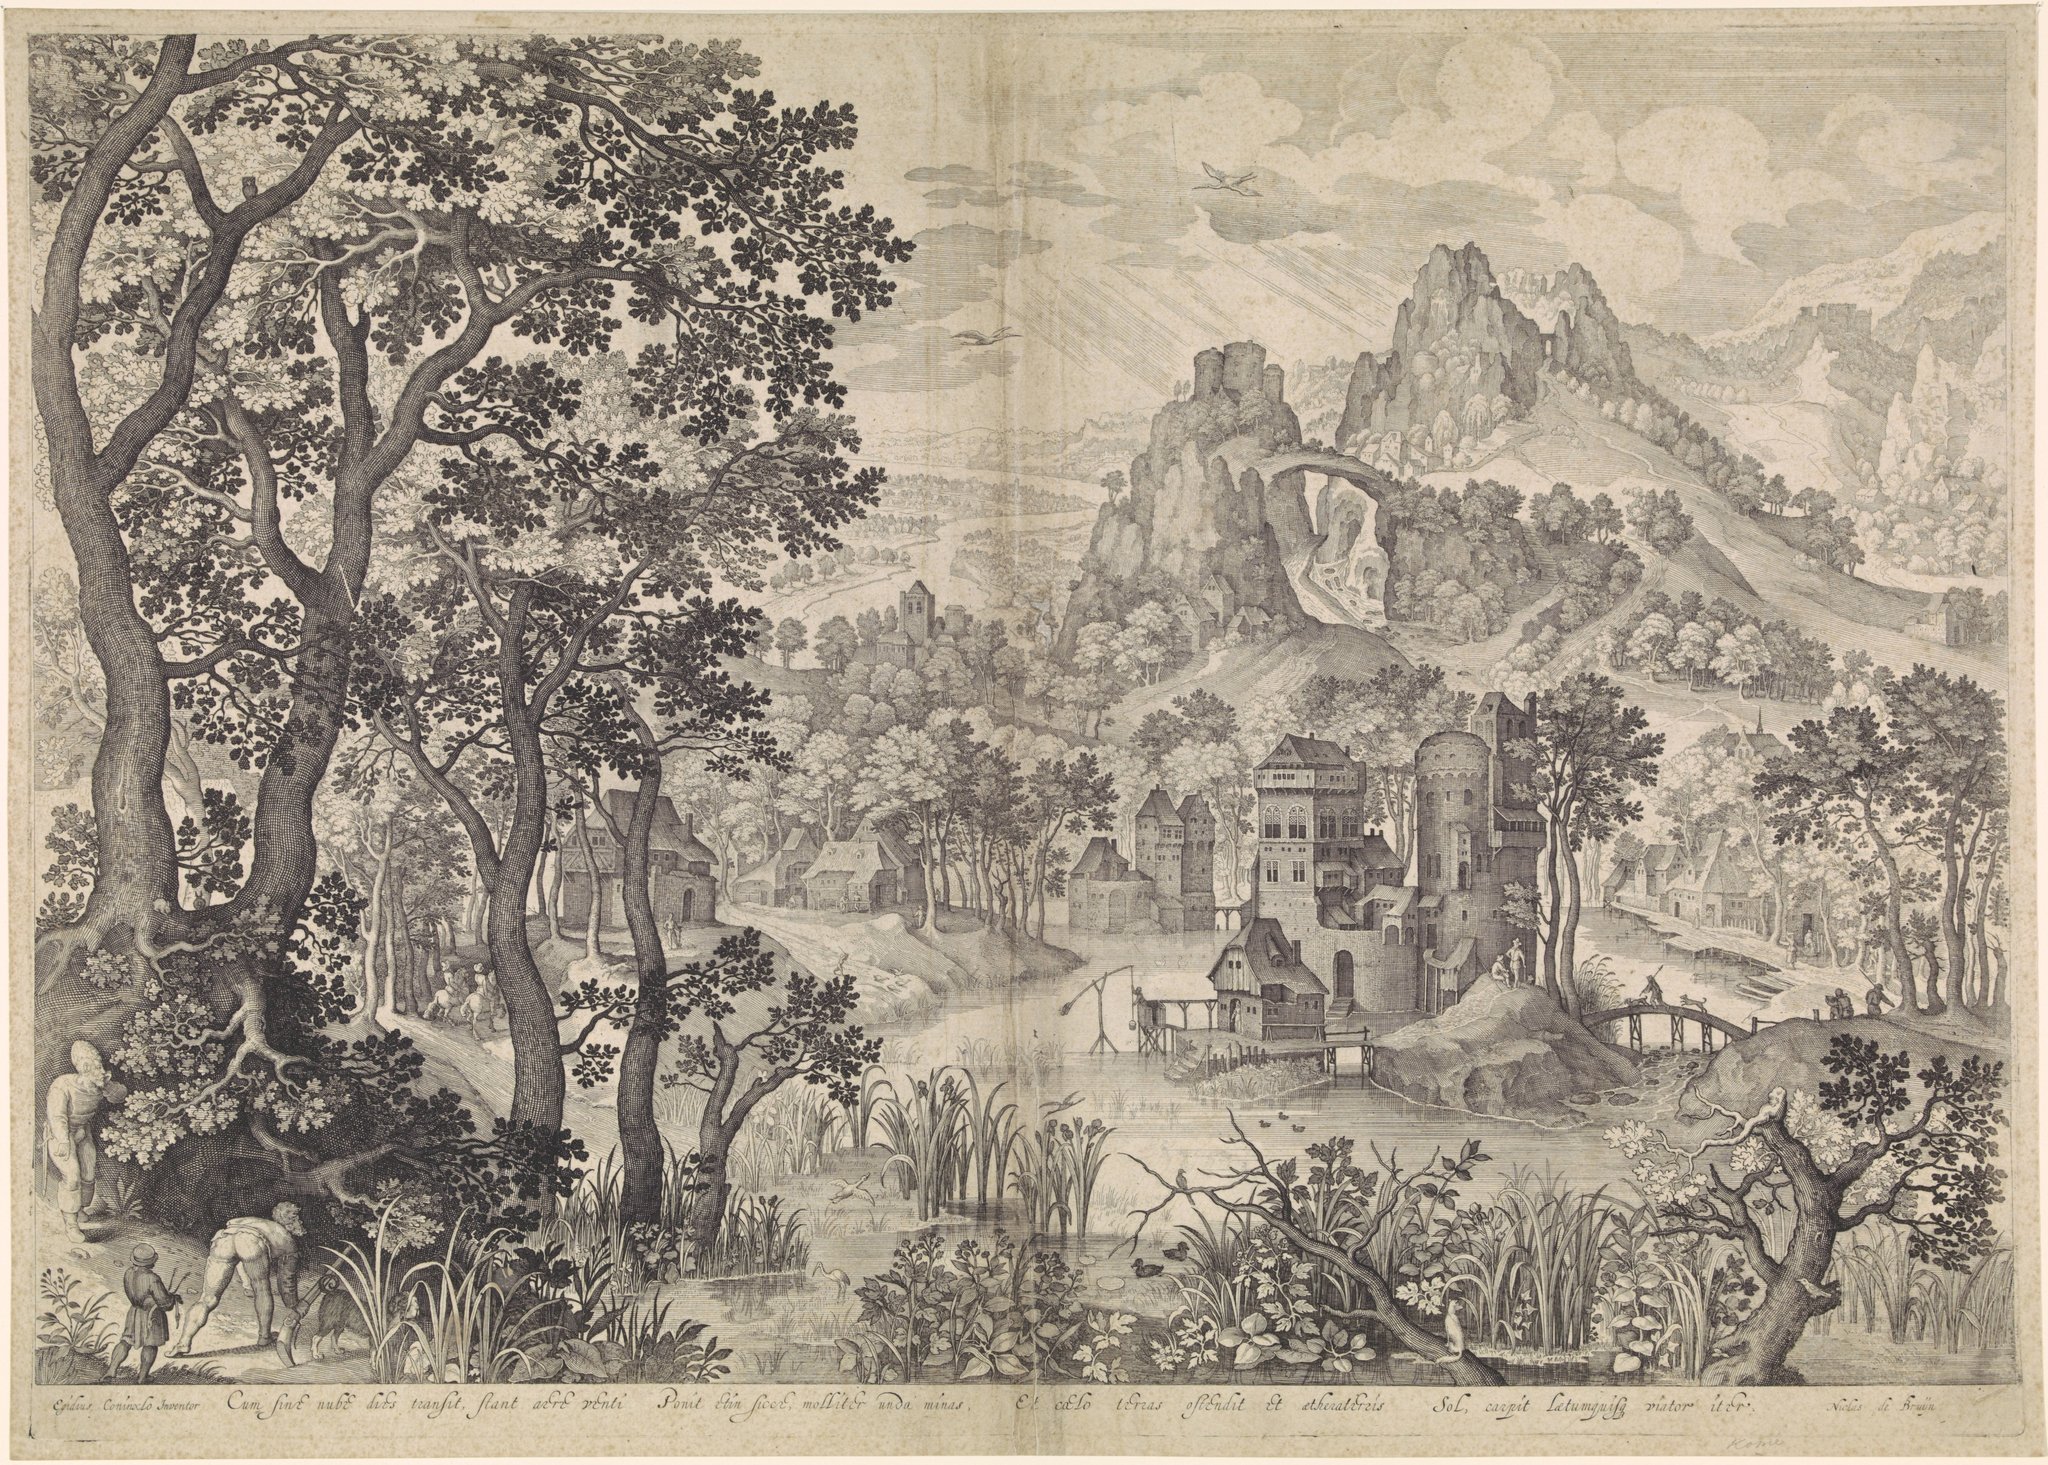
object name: print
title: Landschap met eendenjacht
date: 1600-1706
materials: paper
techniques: etching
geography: antwerp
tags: bird hunting, landscape with tower or castle (+ city(-scape) with figures, staffage)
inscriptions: collector's mark: Lugt 2228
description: Berglandschap met een kasteel. Op de linkervoorgrond twee mannen die jagen op watervogels.